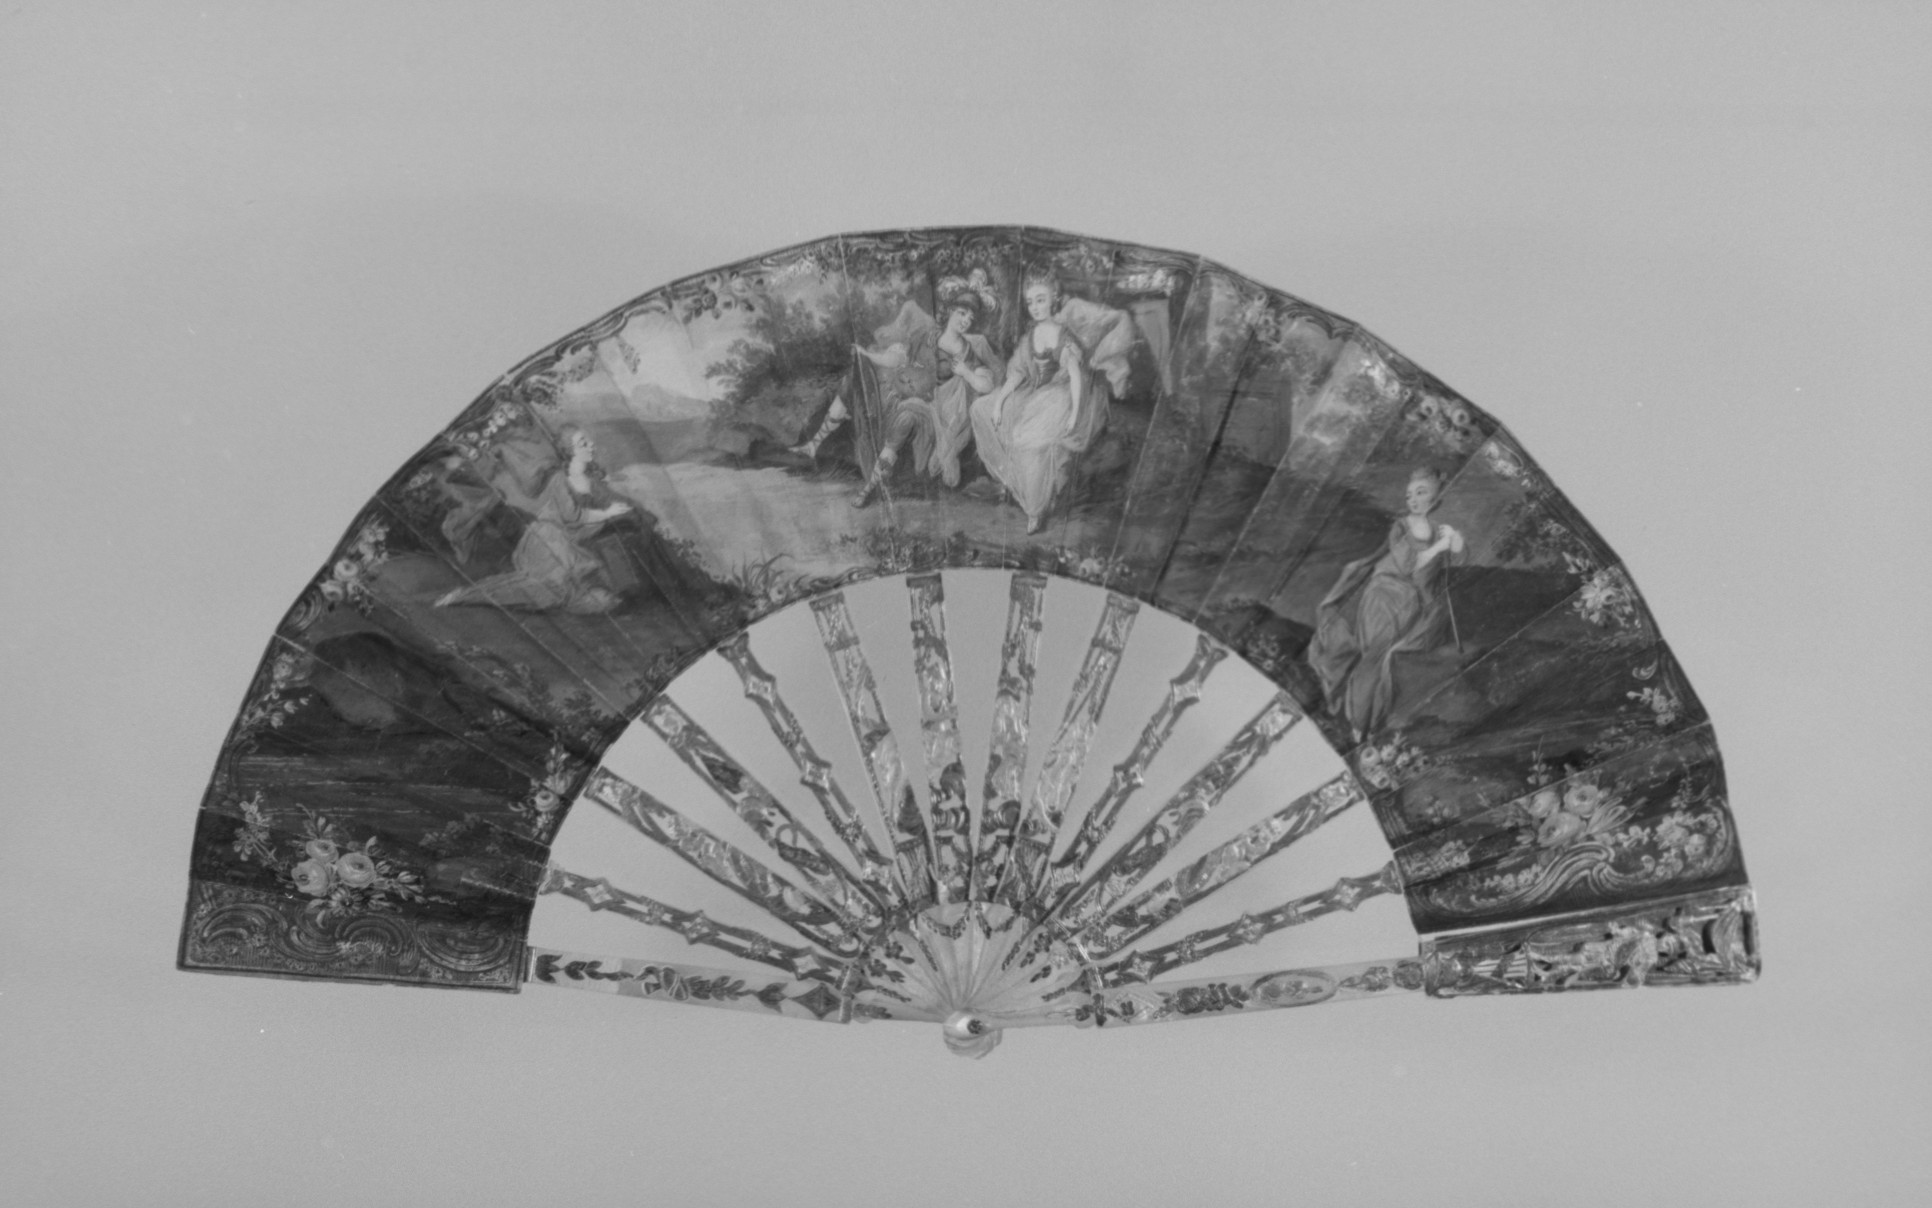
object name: fan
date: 1701-1800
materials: mother of pearl, paper, parchment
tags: men,women